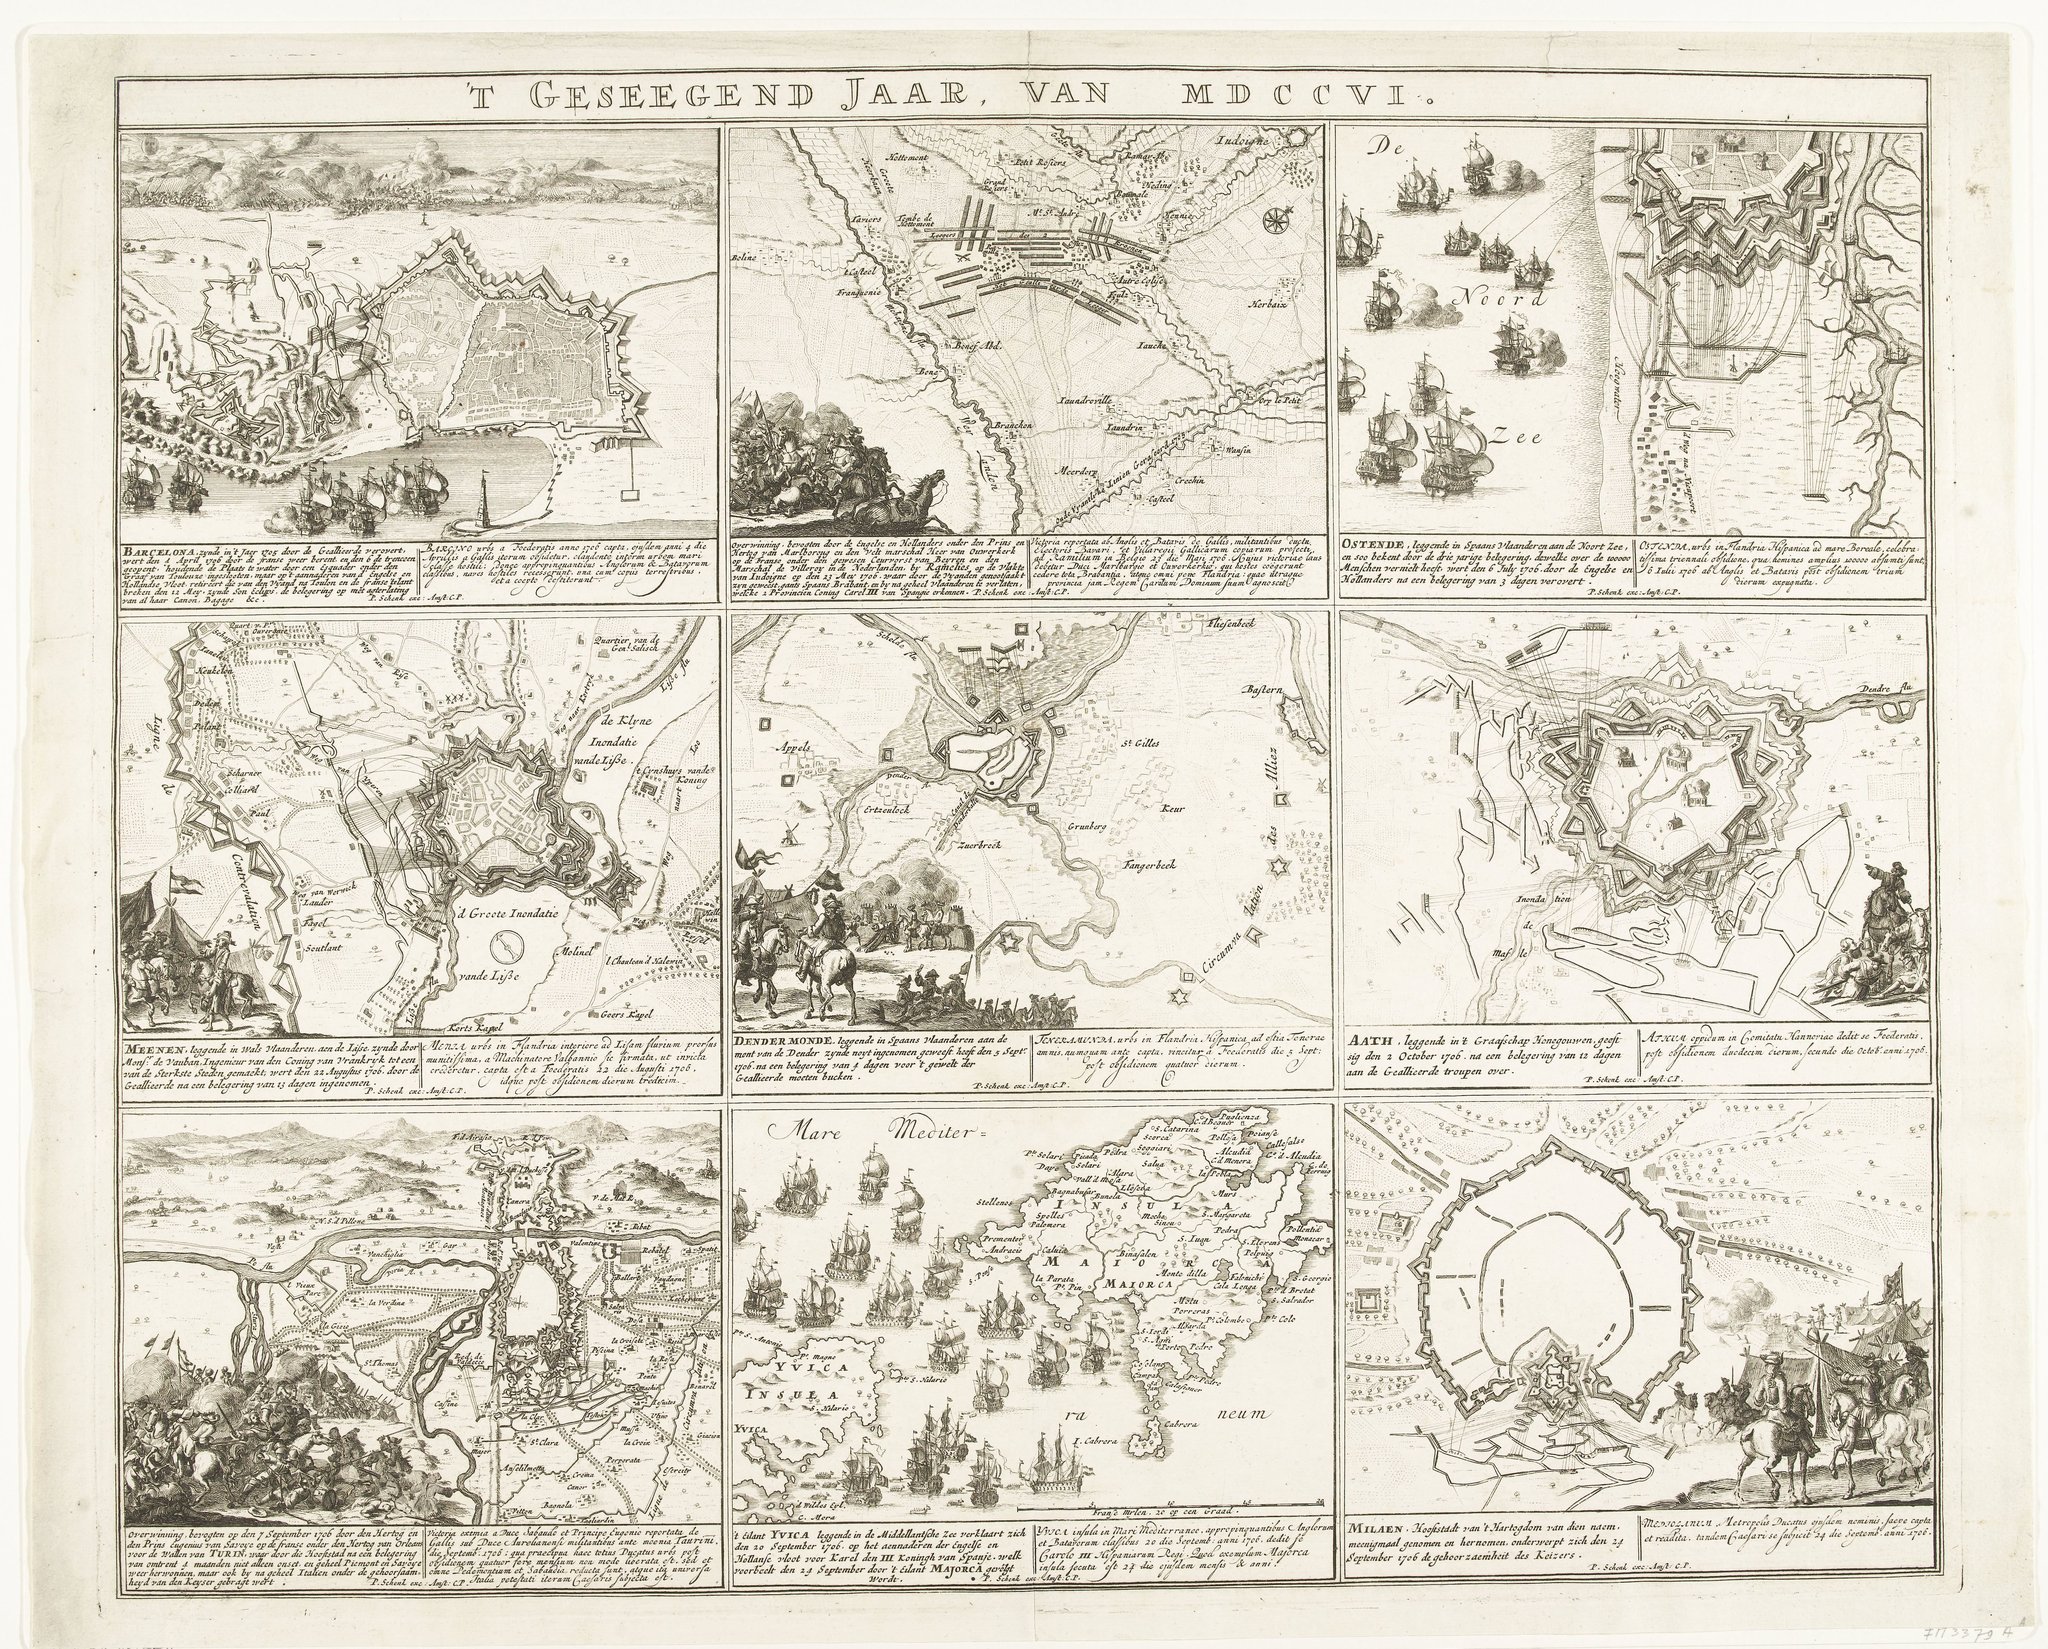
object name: print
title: 't Geseegend Jaar, van MDCCVI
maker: pieter schenk (i)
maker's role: print maker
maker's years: 1660-1711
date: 1706-1707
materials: paper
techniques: etching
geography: amsterdam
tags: fortress, maps of cities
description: Blad met negen voorstellingen van gebeurtenissen uit het jaar 1706 van de Spaanse Successieoorlog en van plattegronden van versterkte steden. Blad VII uit de serie: Schouwburg van den oorlog.